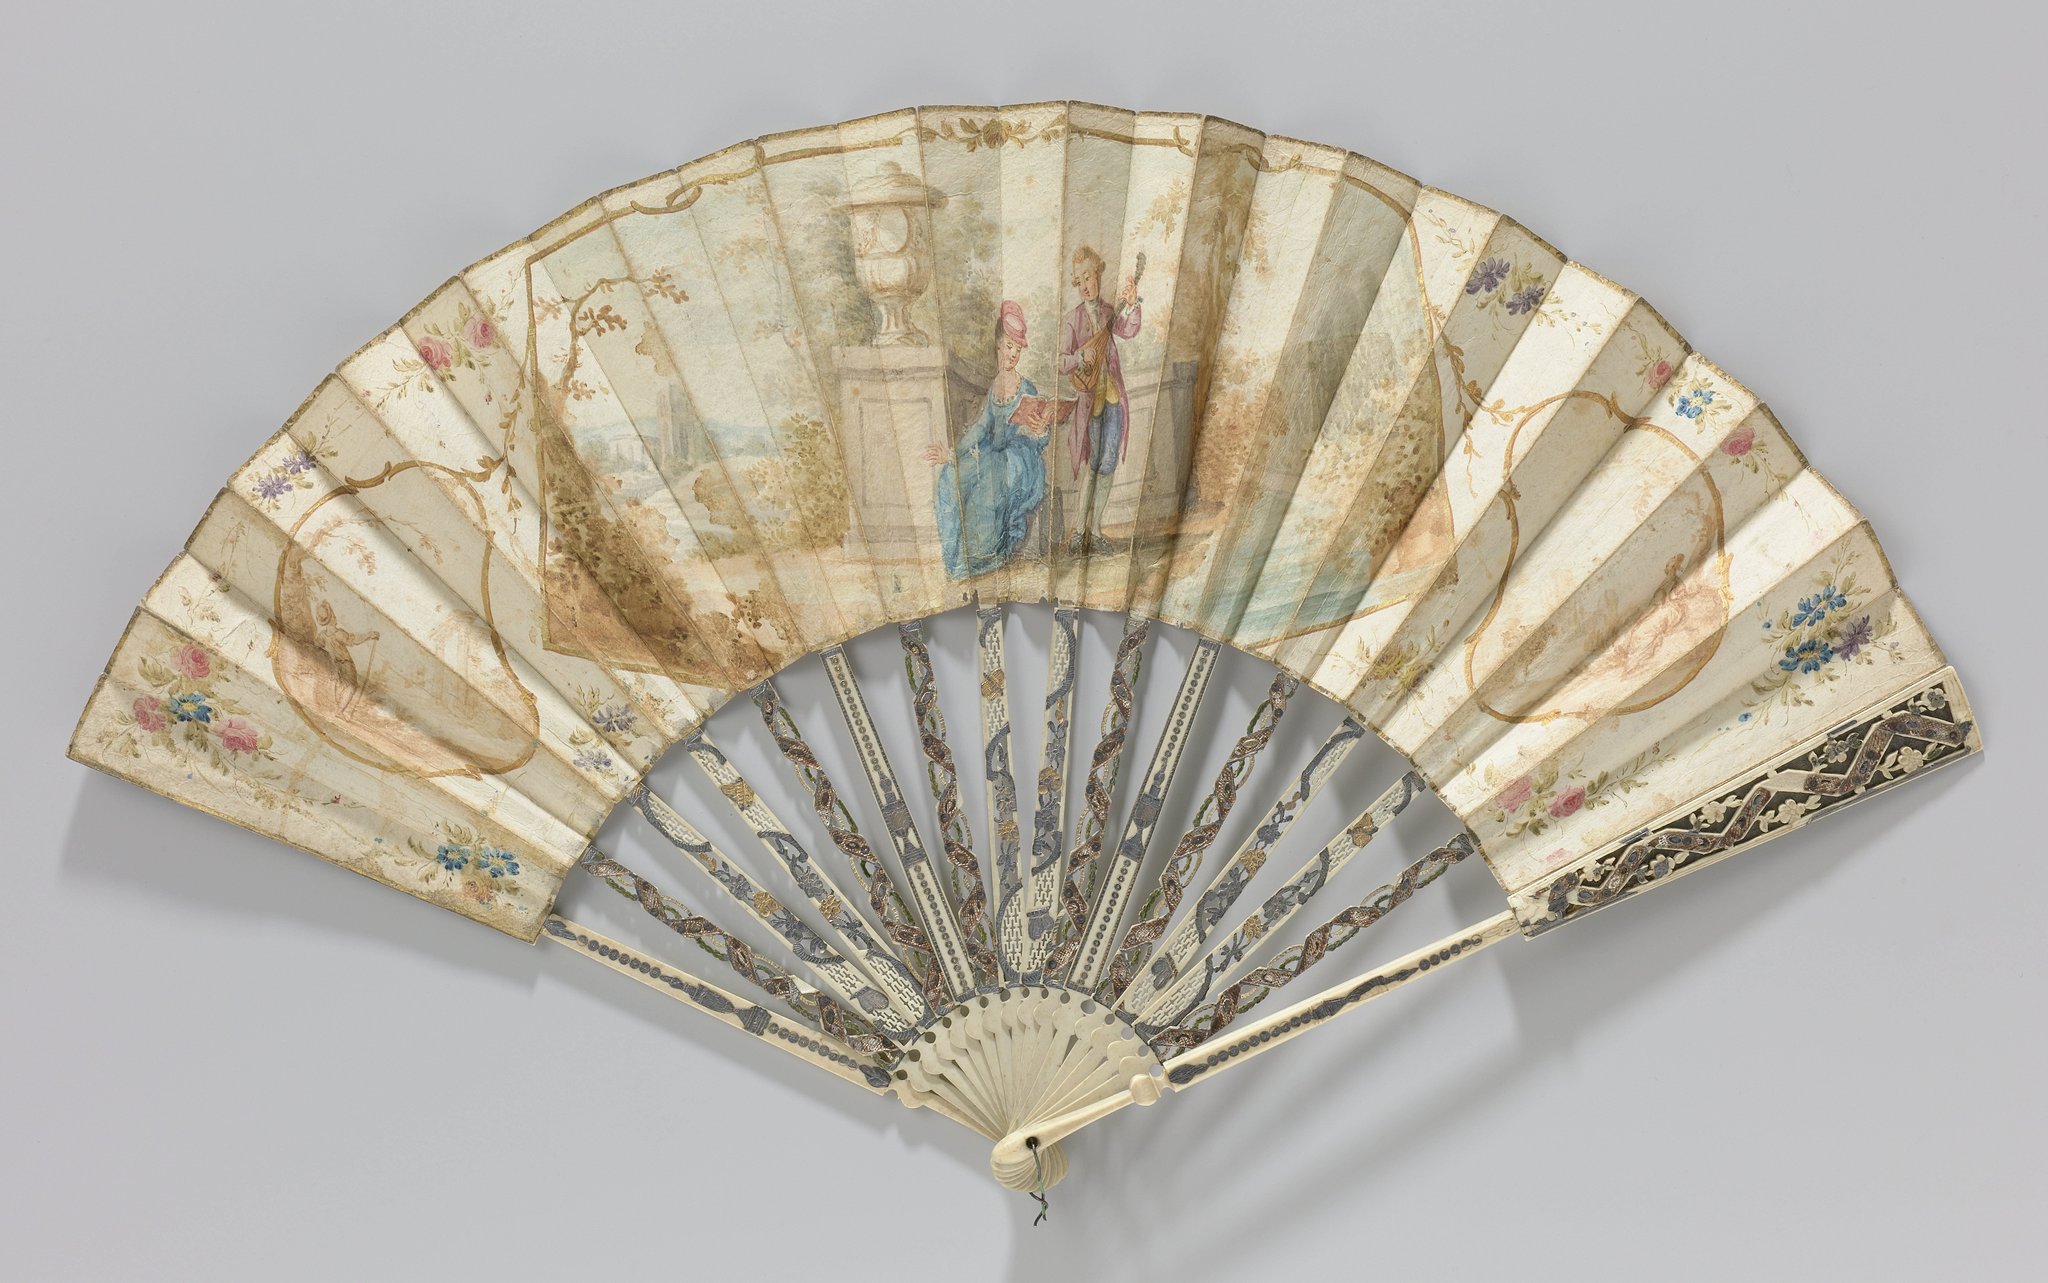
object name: vouwwaaier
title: Vouwwaaier met blad van papier waarop in aquarel een afbeelding van een musicerend paar in een landschap bij een ruïne, montuur ajour gesneden versierd met 'métal en quatre couleurs'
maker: Anonymous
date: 1775-1800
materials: paint, ivory, metal, paper, watercolor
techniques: aquarelle, cutting, embroidery, inlay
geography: netherlands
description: Vouwwaaier met blad van papier waarop in aquarel geschilderd: een centrale cartouche met een musicerend paar in romantisch landschap met ruïne en bergen; links een cartouche met een herder bij een klassieke ruïne en rechts een cartouche met een herderin, beide in sepia. Hier omheen bloemenguirlandes. Op een heuveltje. Open montuur van ajour gesneden ivoor (?) versierd met "métal en quatre couleurs". Op de 16 niet aaneengesloten benen neo-classicistische versieringen, zoals urnen. Sluitpin ontbreekt.